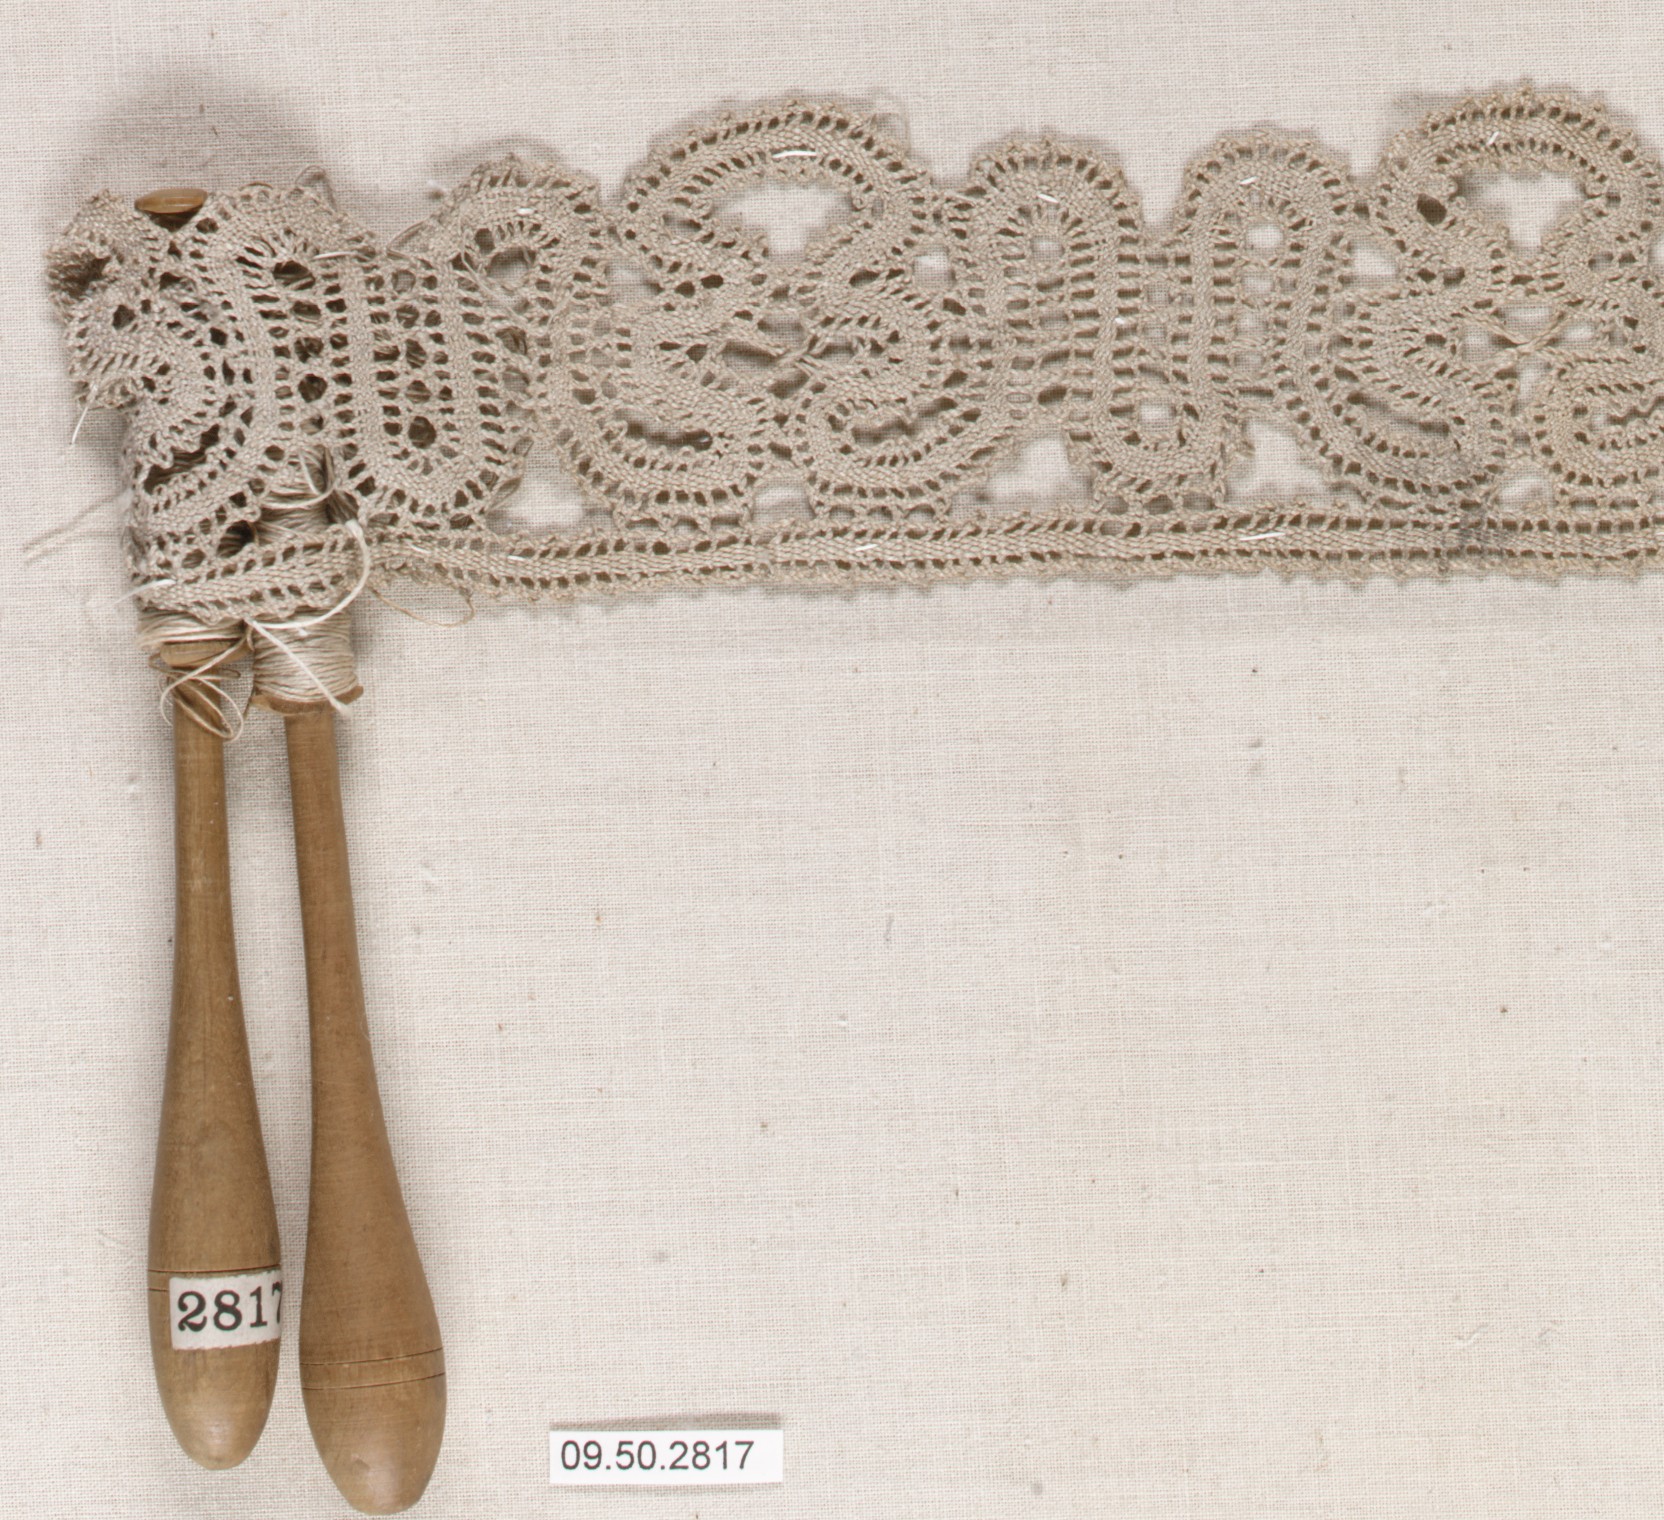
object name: fragment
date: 1801-1900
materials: lace